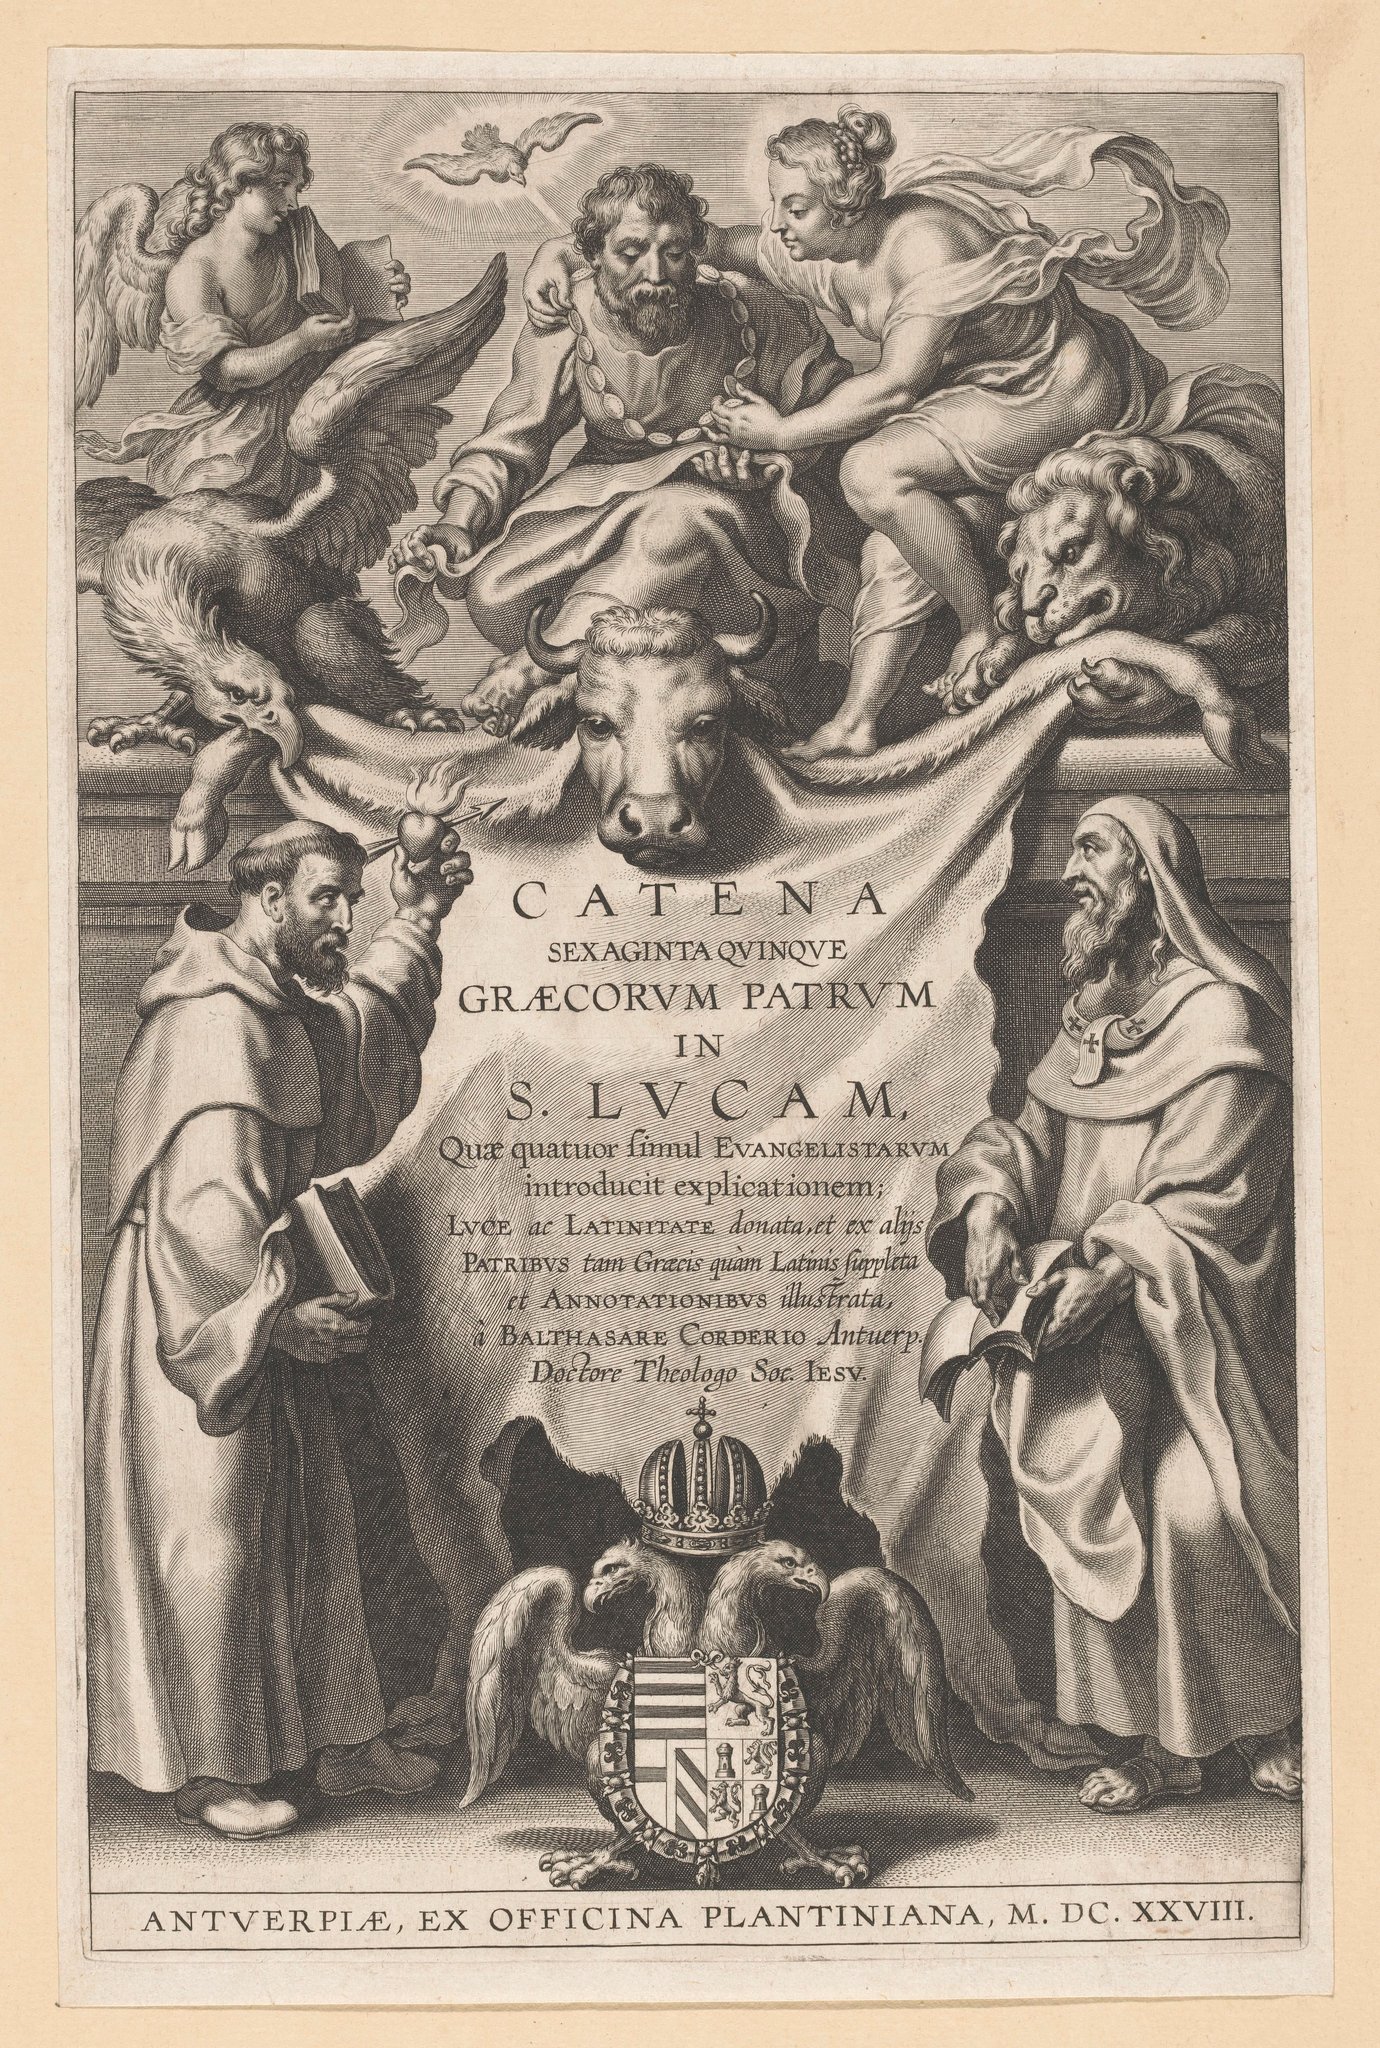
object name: print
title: Titelpagina voor: B. Cordier, Catena sexaginta quinque graecorum patrum in S. Lucam, Antwerpen: 1628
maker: cornelis galle (i)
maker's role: print maker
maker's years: 1576-1650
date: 1628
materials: paper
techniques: engraving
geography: antwerp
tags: augustine, bishop of hippo; possible attributes: arrows piercing his breast, book, child with spoon, flaming heart, heart (pierced with arrows), pen, title-page, truth; 'verità' (ripa), the four symbols of the evangelists, 'the apocalyptic beasts', athanasius the great, bishop of alexandria; possible attributes: book, heretic under feet, scroll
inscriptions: collector's mark: Lugt 240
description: De twee kerkvaderen Augustinus (links) en Athanasius (rechts) naast een ossenhuid met de titel van het boek. De os, de leeuw, de adelaar en de engel staan symbool voor de evangelisten. De evangelist Lucas zit boven de ossenkop en krijgt een ketting van de personificatie van de Waarheid. Onder het wapen van keizer Ferdinand II.